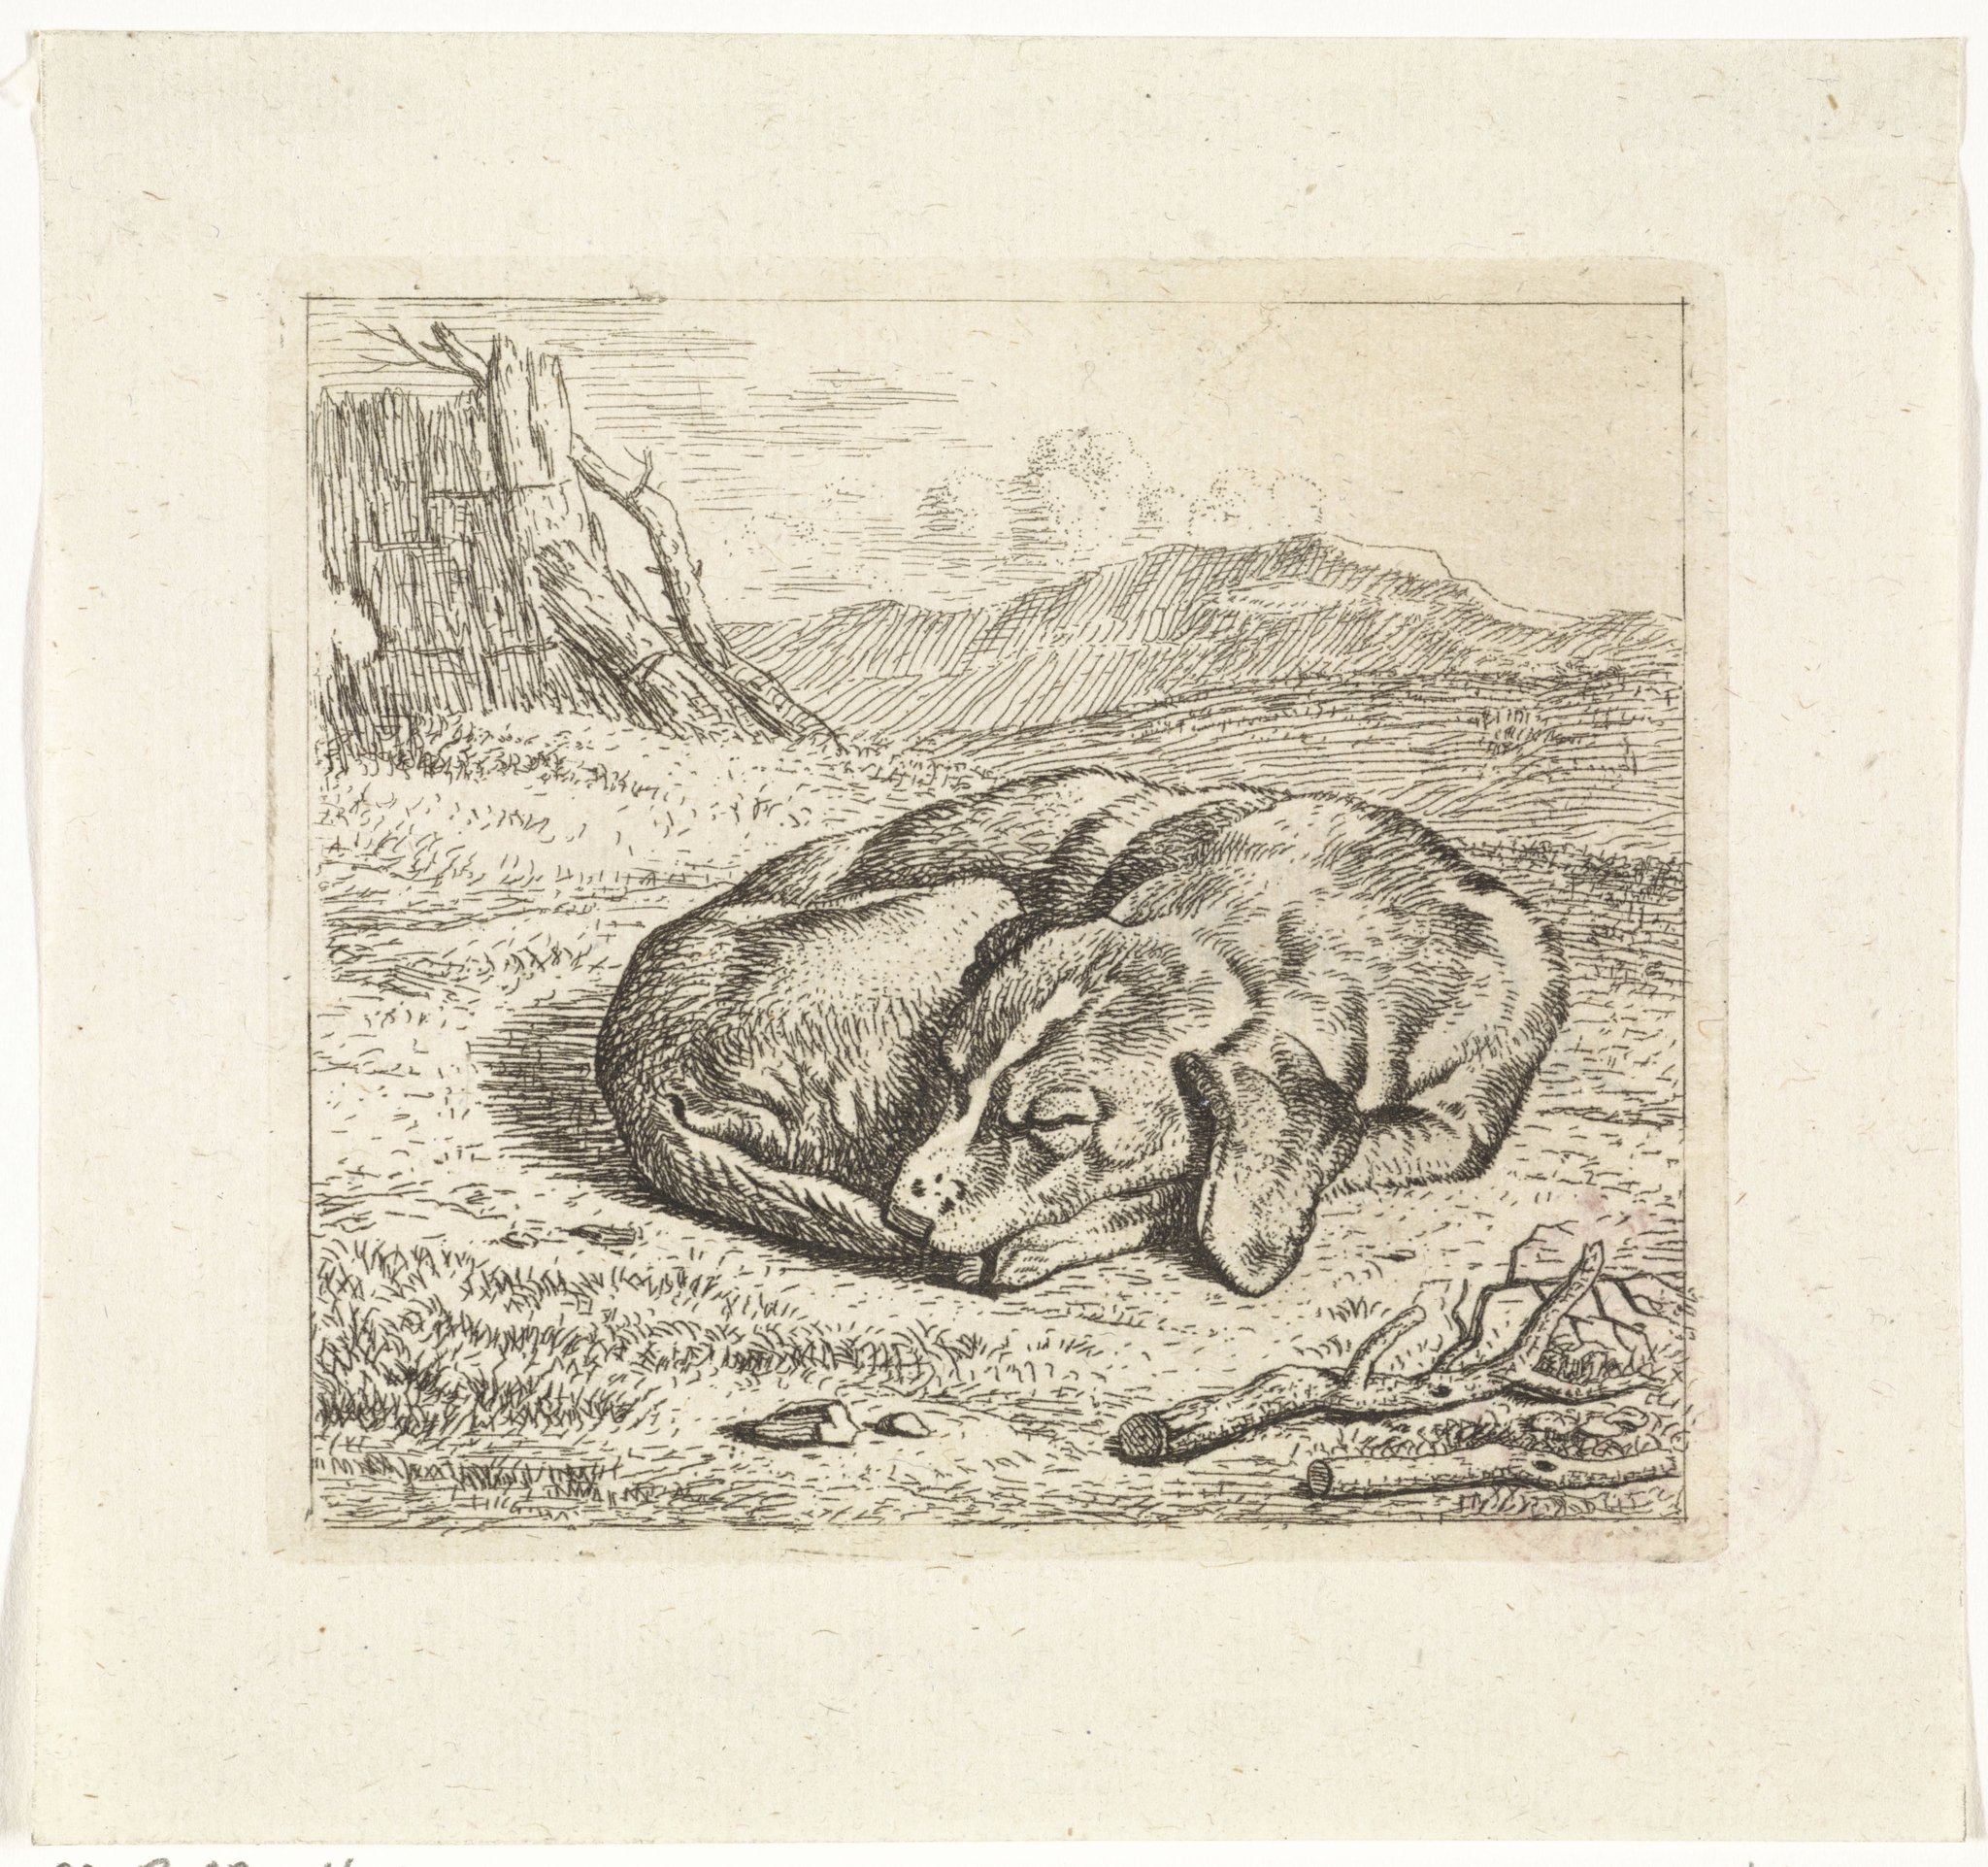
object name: print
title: Slapende hond in landschap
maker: wouter johannes van troostwijk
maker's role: draughtsman, painter, print maker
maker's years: 1782-1810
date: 1792-1810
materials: paper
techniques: etching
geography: amsterdam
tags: dog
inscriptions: collector's mark: Lugt 12